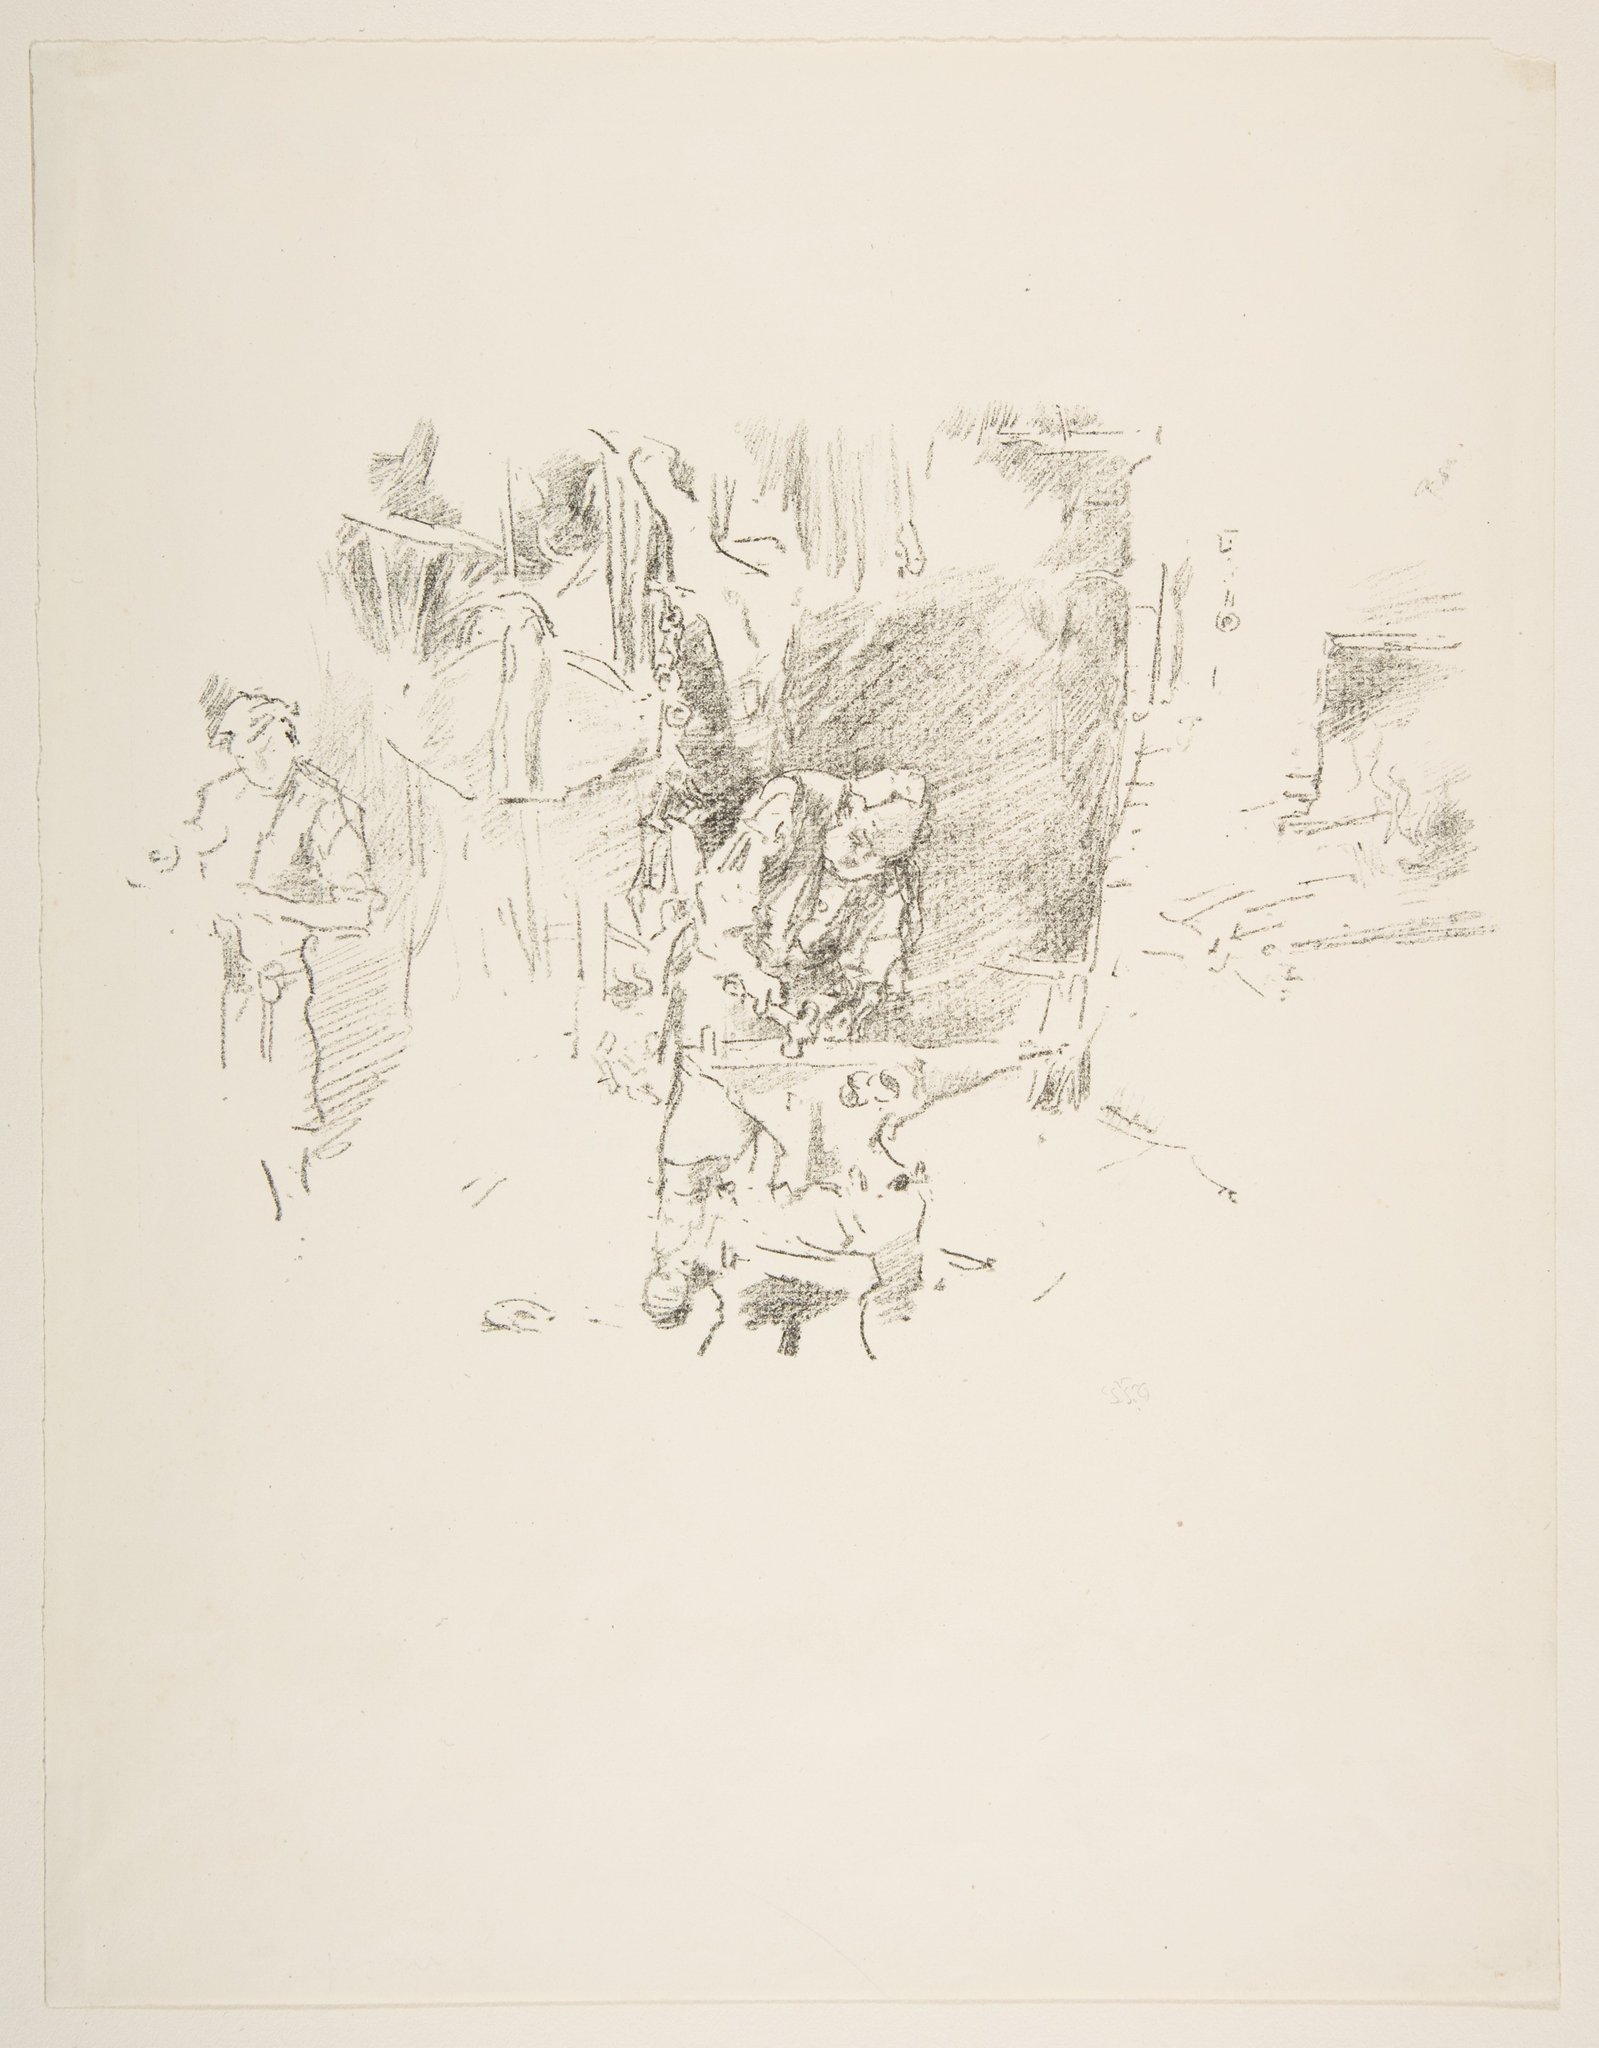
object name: print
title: The Sunny Smithy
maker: james mcneill whistler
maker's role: artist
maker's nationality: american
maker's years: 1834-1903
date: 1895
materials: ink, paper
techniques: printing, lithography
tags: men,working